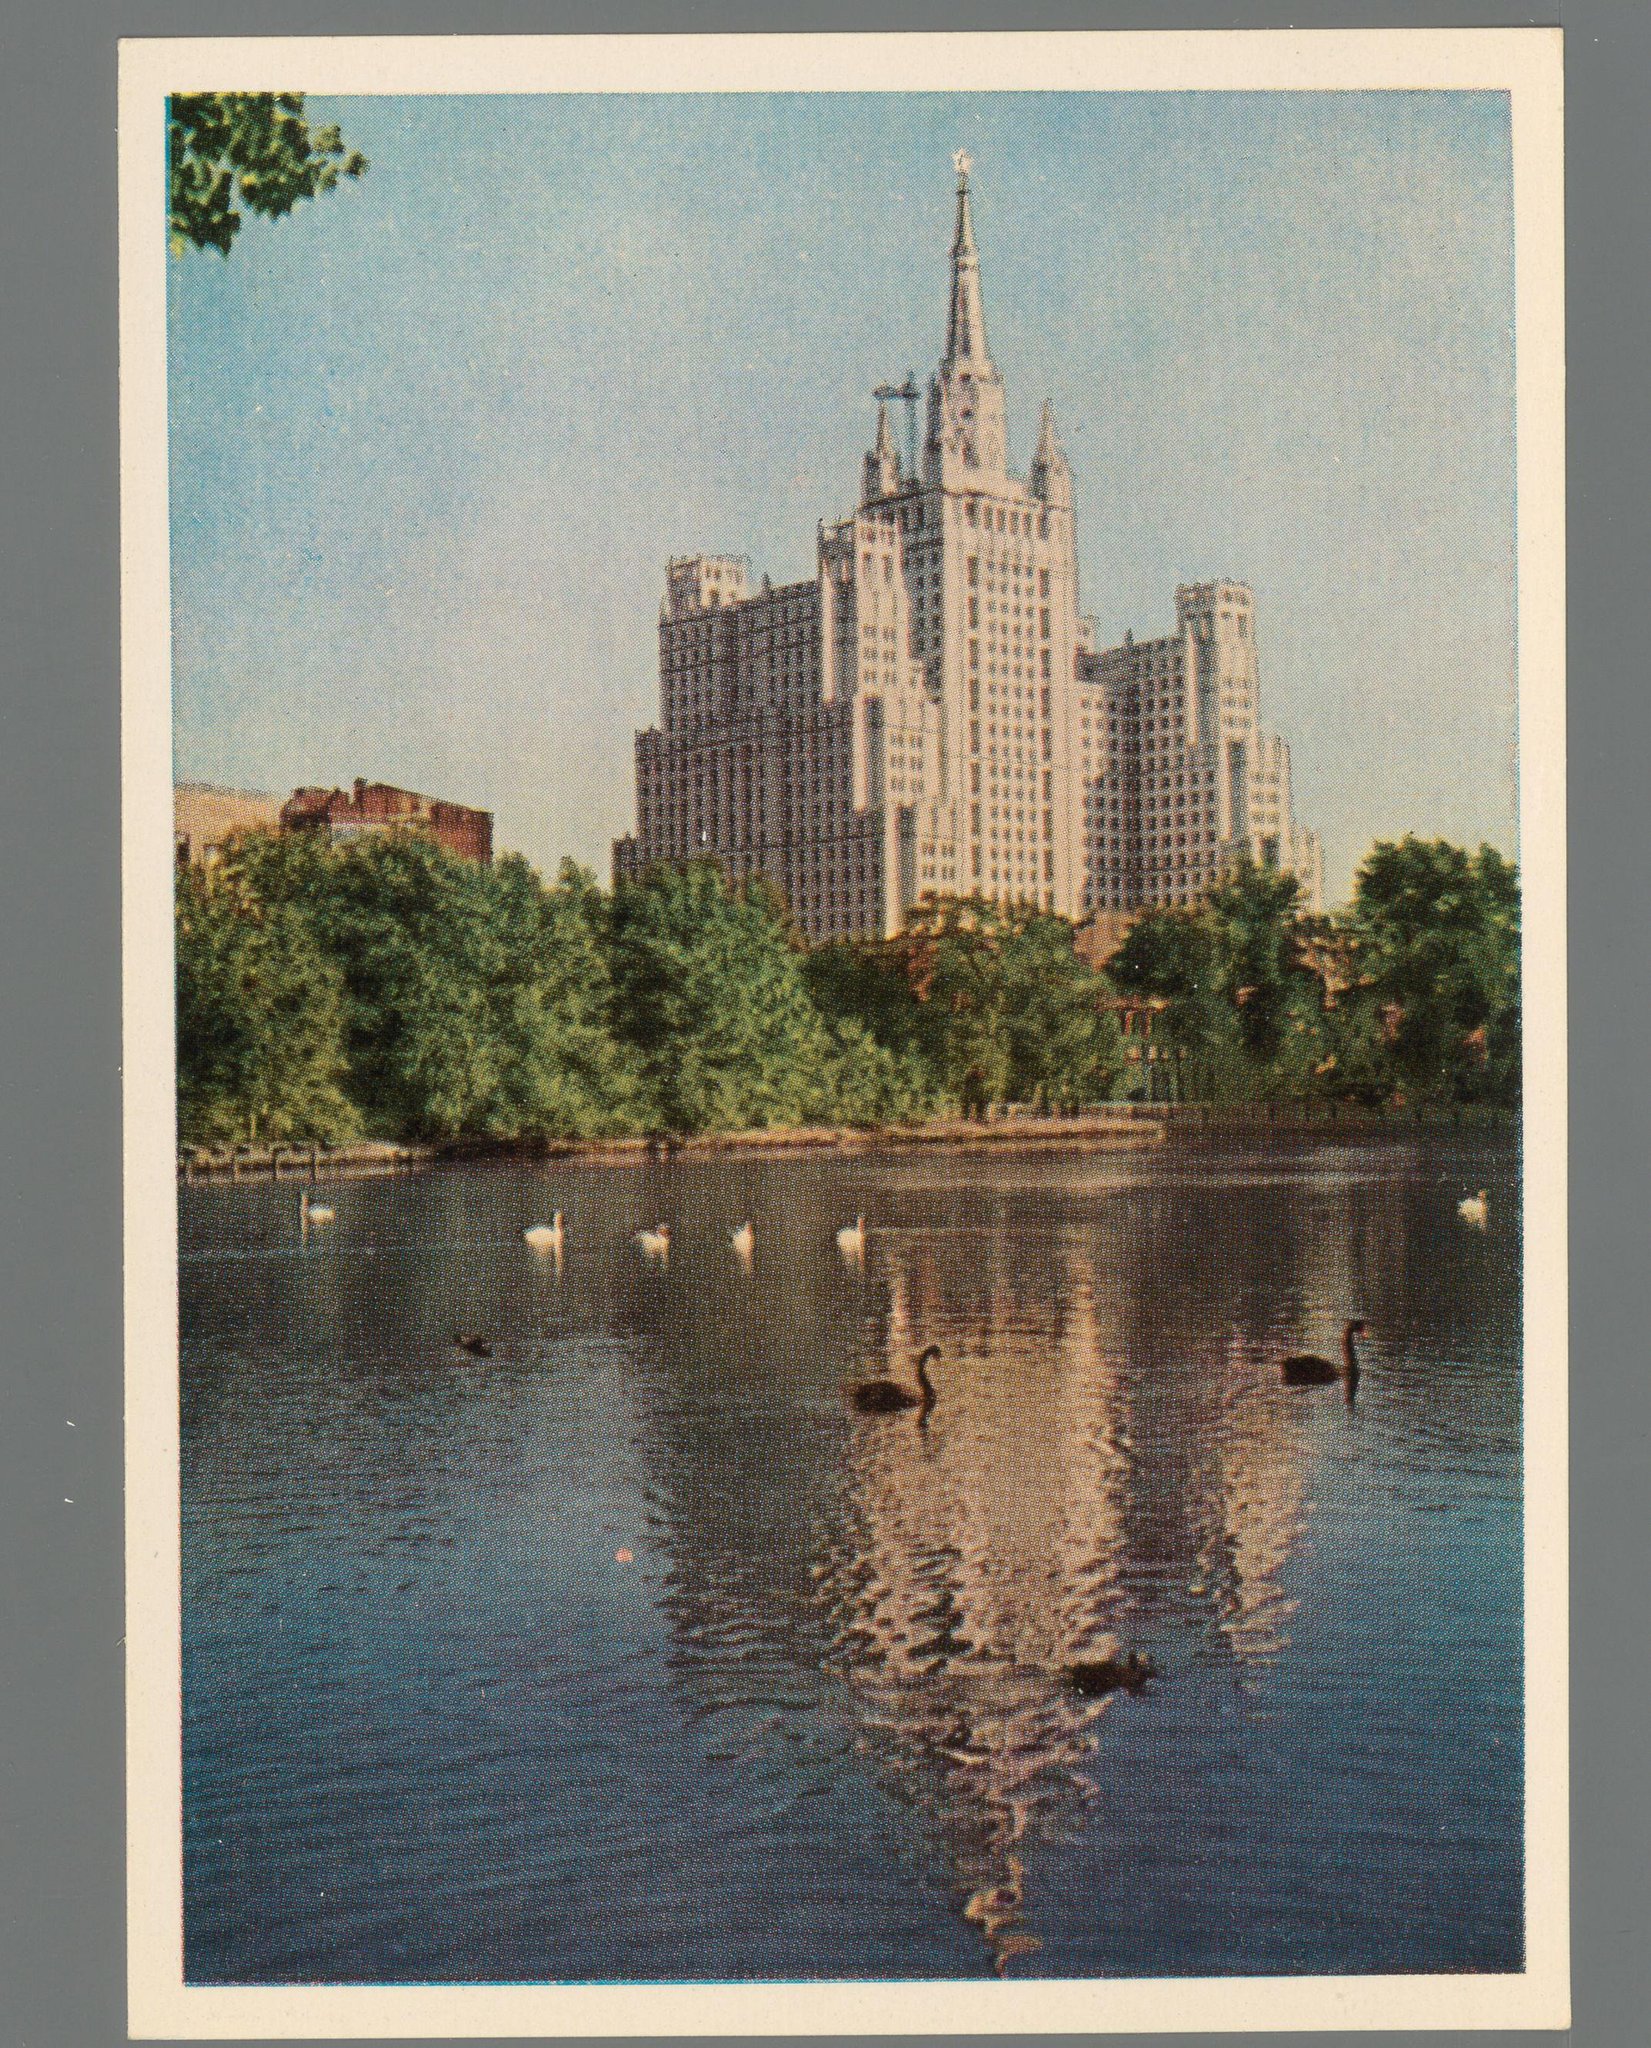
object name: ansichtkaart, prentbriefkaart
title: Moscow. A corner of the Zoo / Moskau. Im Zoologischen Garten / Moscou. Un coin du Jardin Zoologique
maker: Anonymous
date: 1956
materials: cardboard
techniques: color autotype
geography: moscow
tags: zoological garden, zoo, seen as place where non-domestic animals are kept, pond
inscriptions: date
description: De titel op object staat ook in het Russisch.